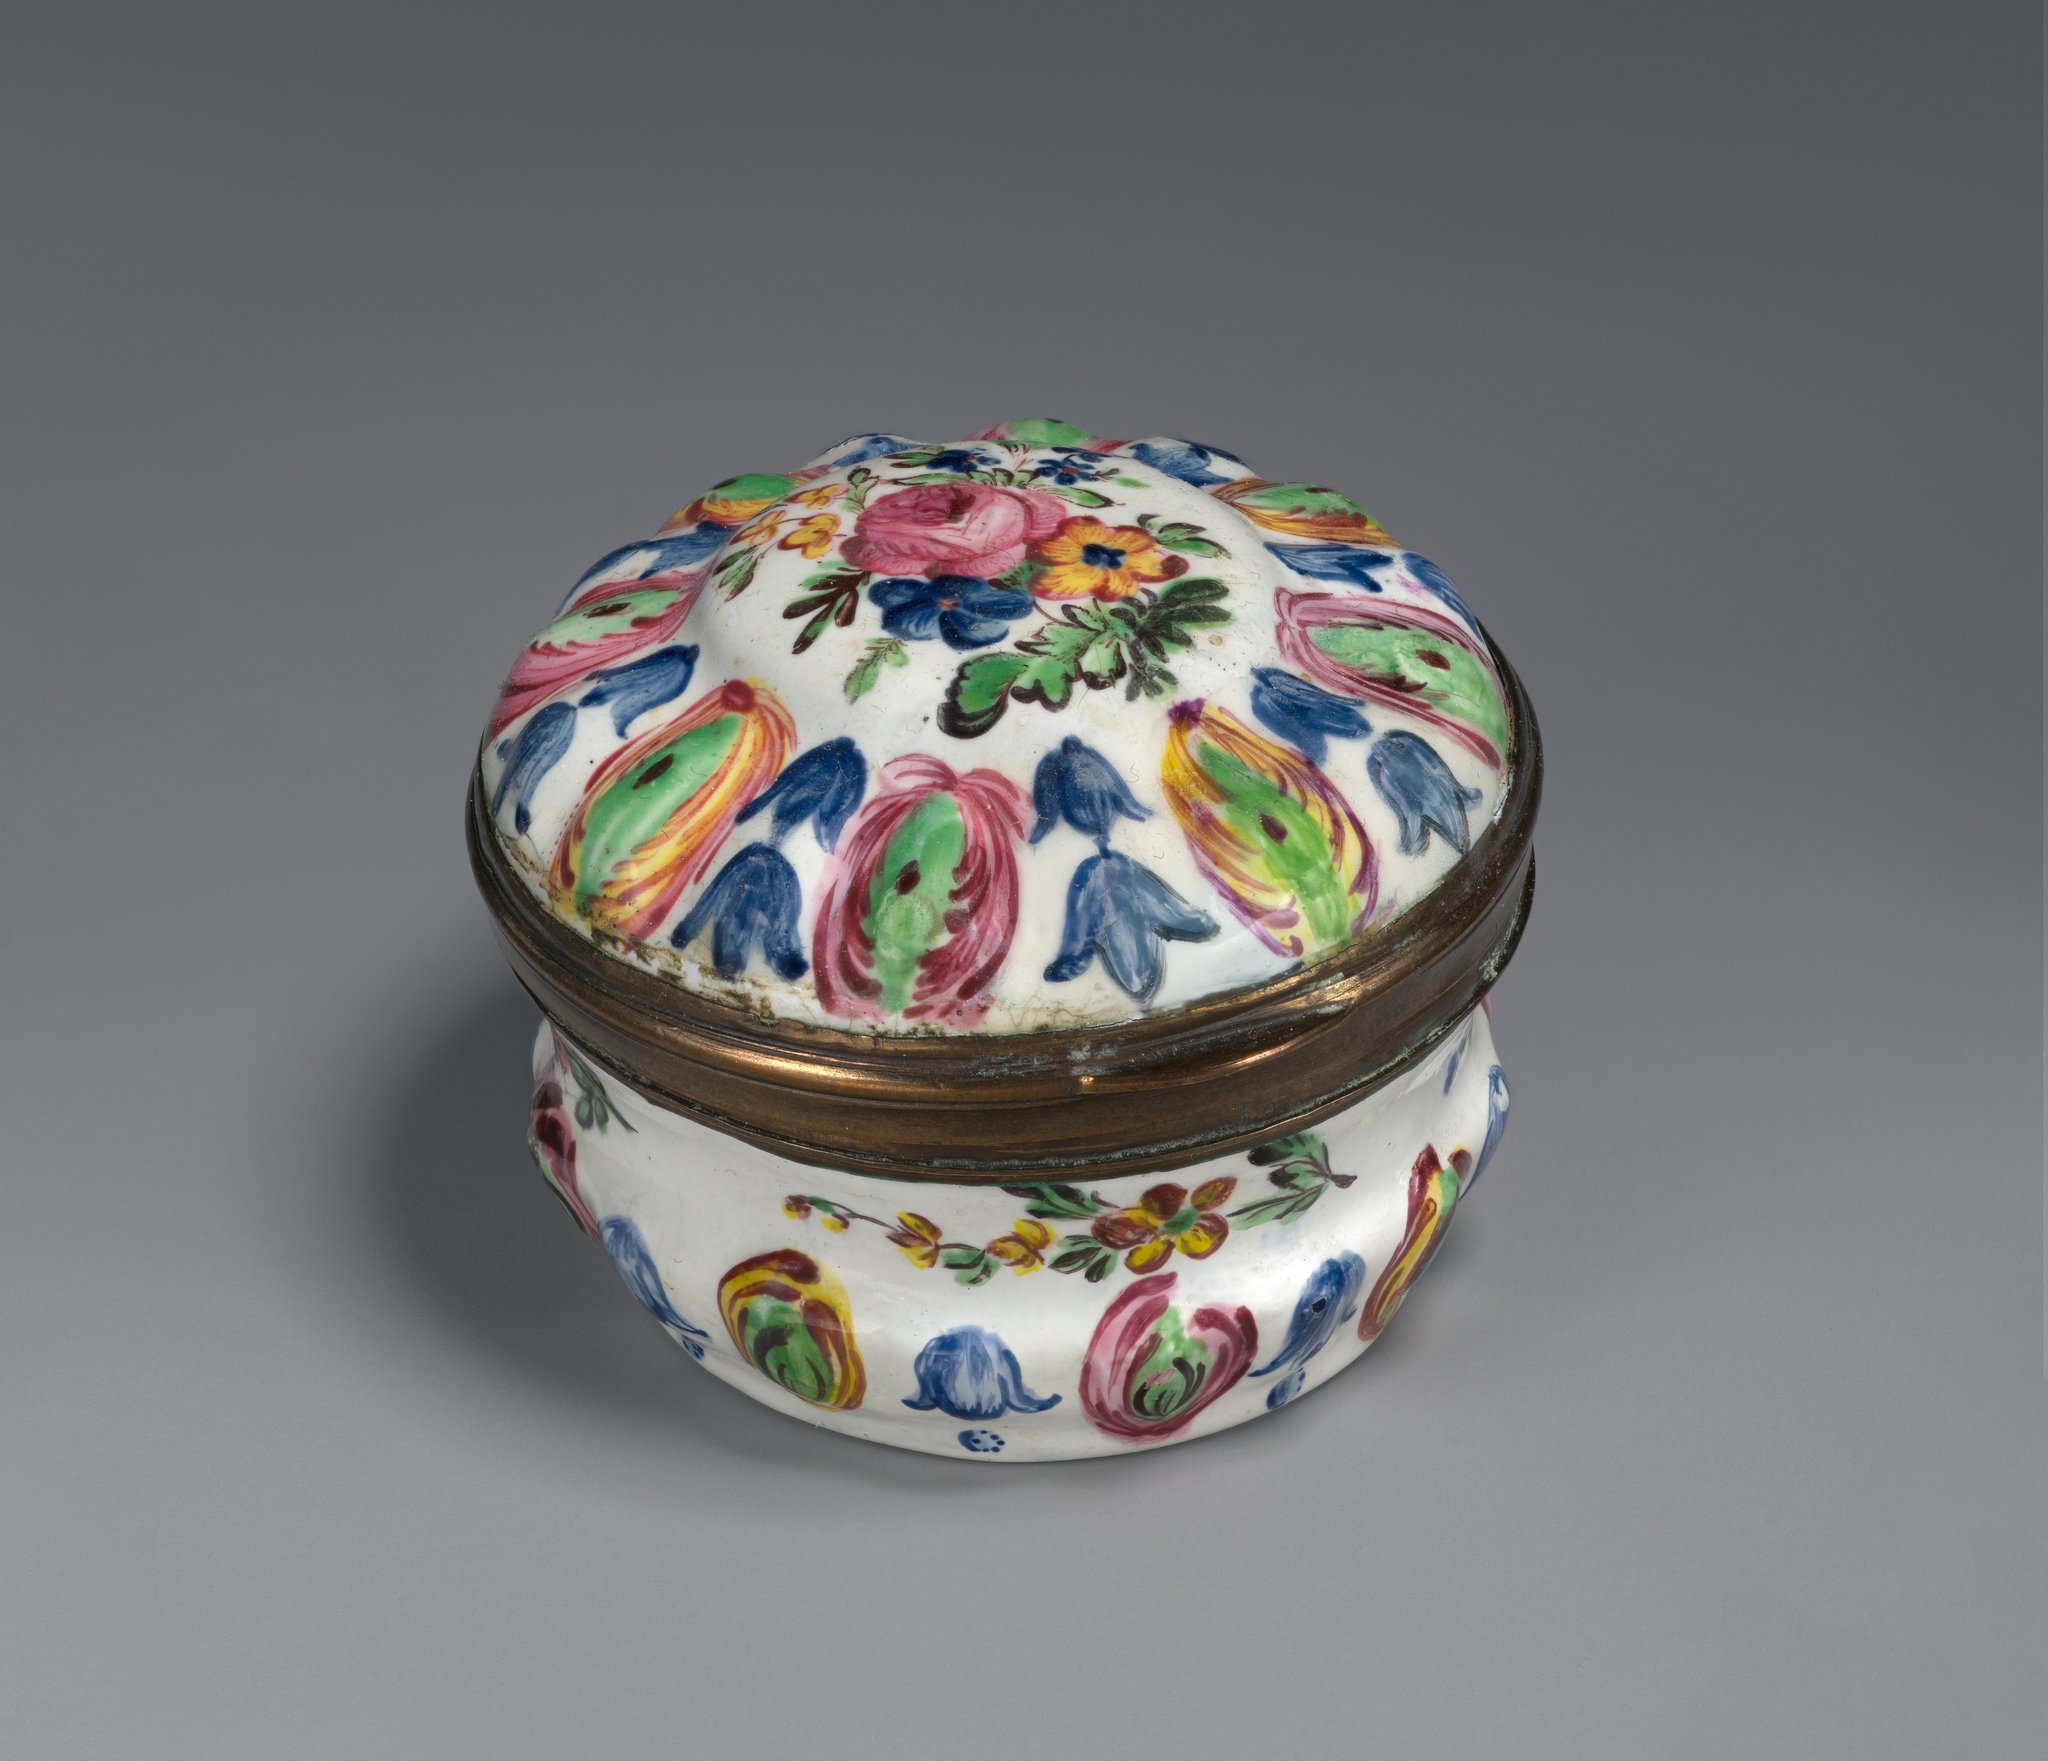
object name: patch box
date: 1770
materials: copper, enamel, glass